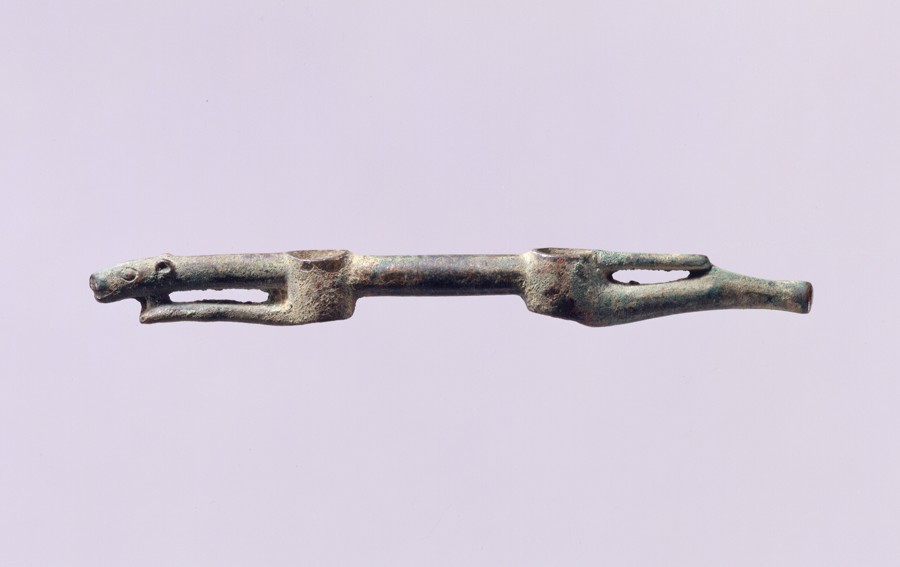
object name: bridle fitting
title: Cheekpiece for Bridle in the Shape of a Leopard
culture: chinese, northeast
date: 600-301 BCE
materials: bronze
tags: leopards